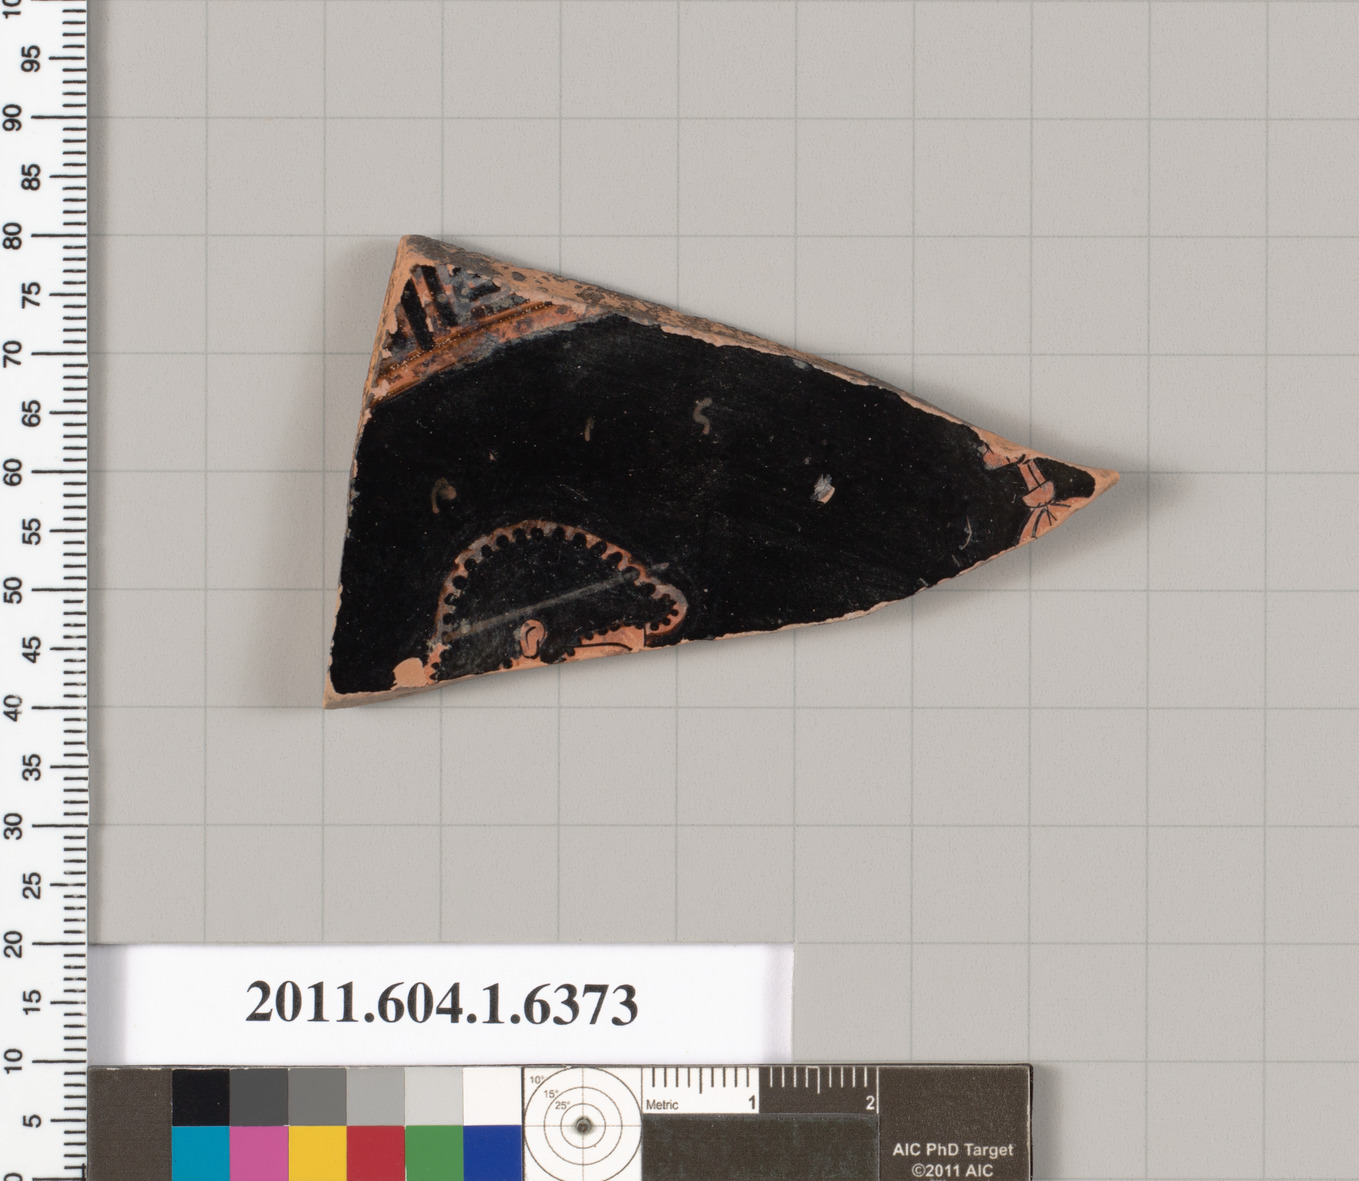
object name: kylix fragment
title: Terracotta fragment of a kylix (drinking cup)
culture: greek, attic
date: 490-480 BCE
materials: terracotta